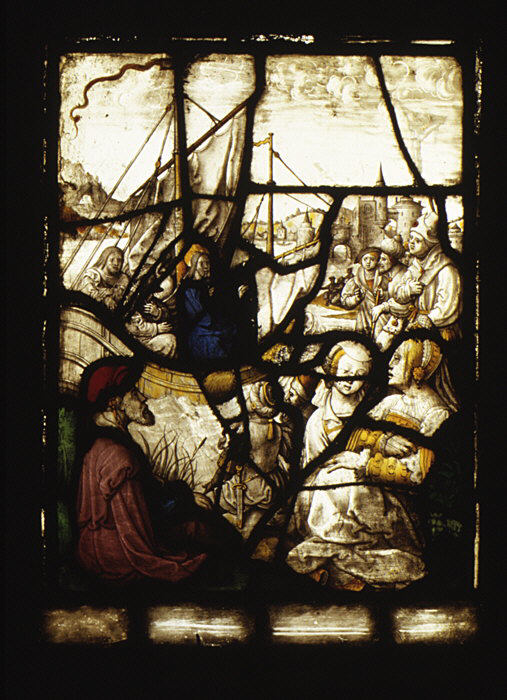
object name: panel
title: Christ Preaching from a Boat in the Lake of Gennesaret (one of a set of 12 scenes from The Life of Christ)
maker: jan rombouts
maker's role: maker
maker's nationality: south netherlandish (duchy of brabant)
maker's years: 1475-1535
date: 1525-1530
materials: glass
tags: men,women,christ,boats